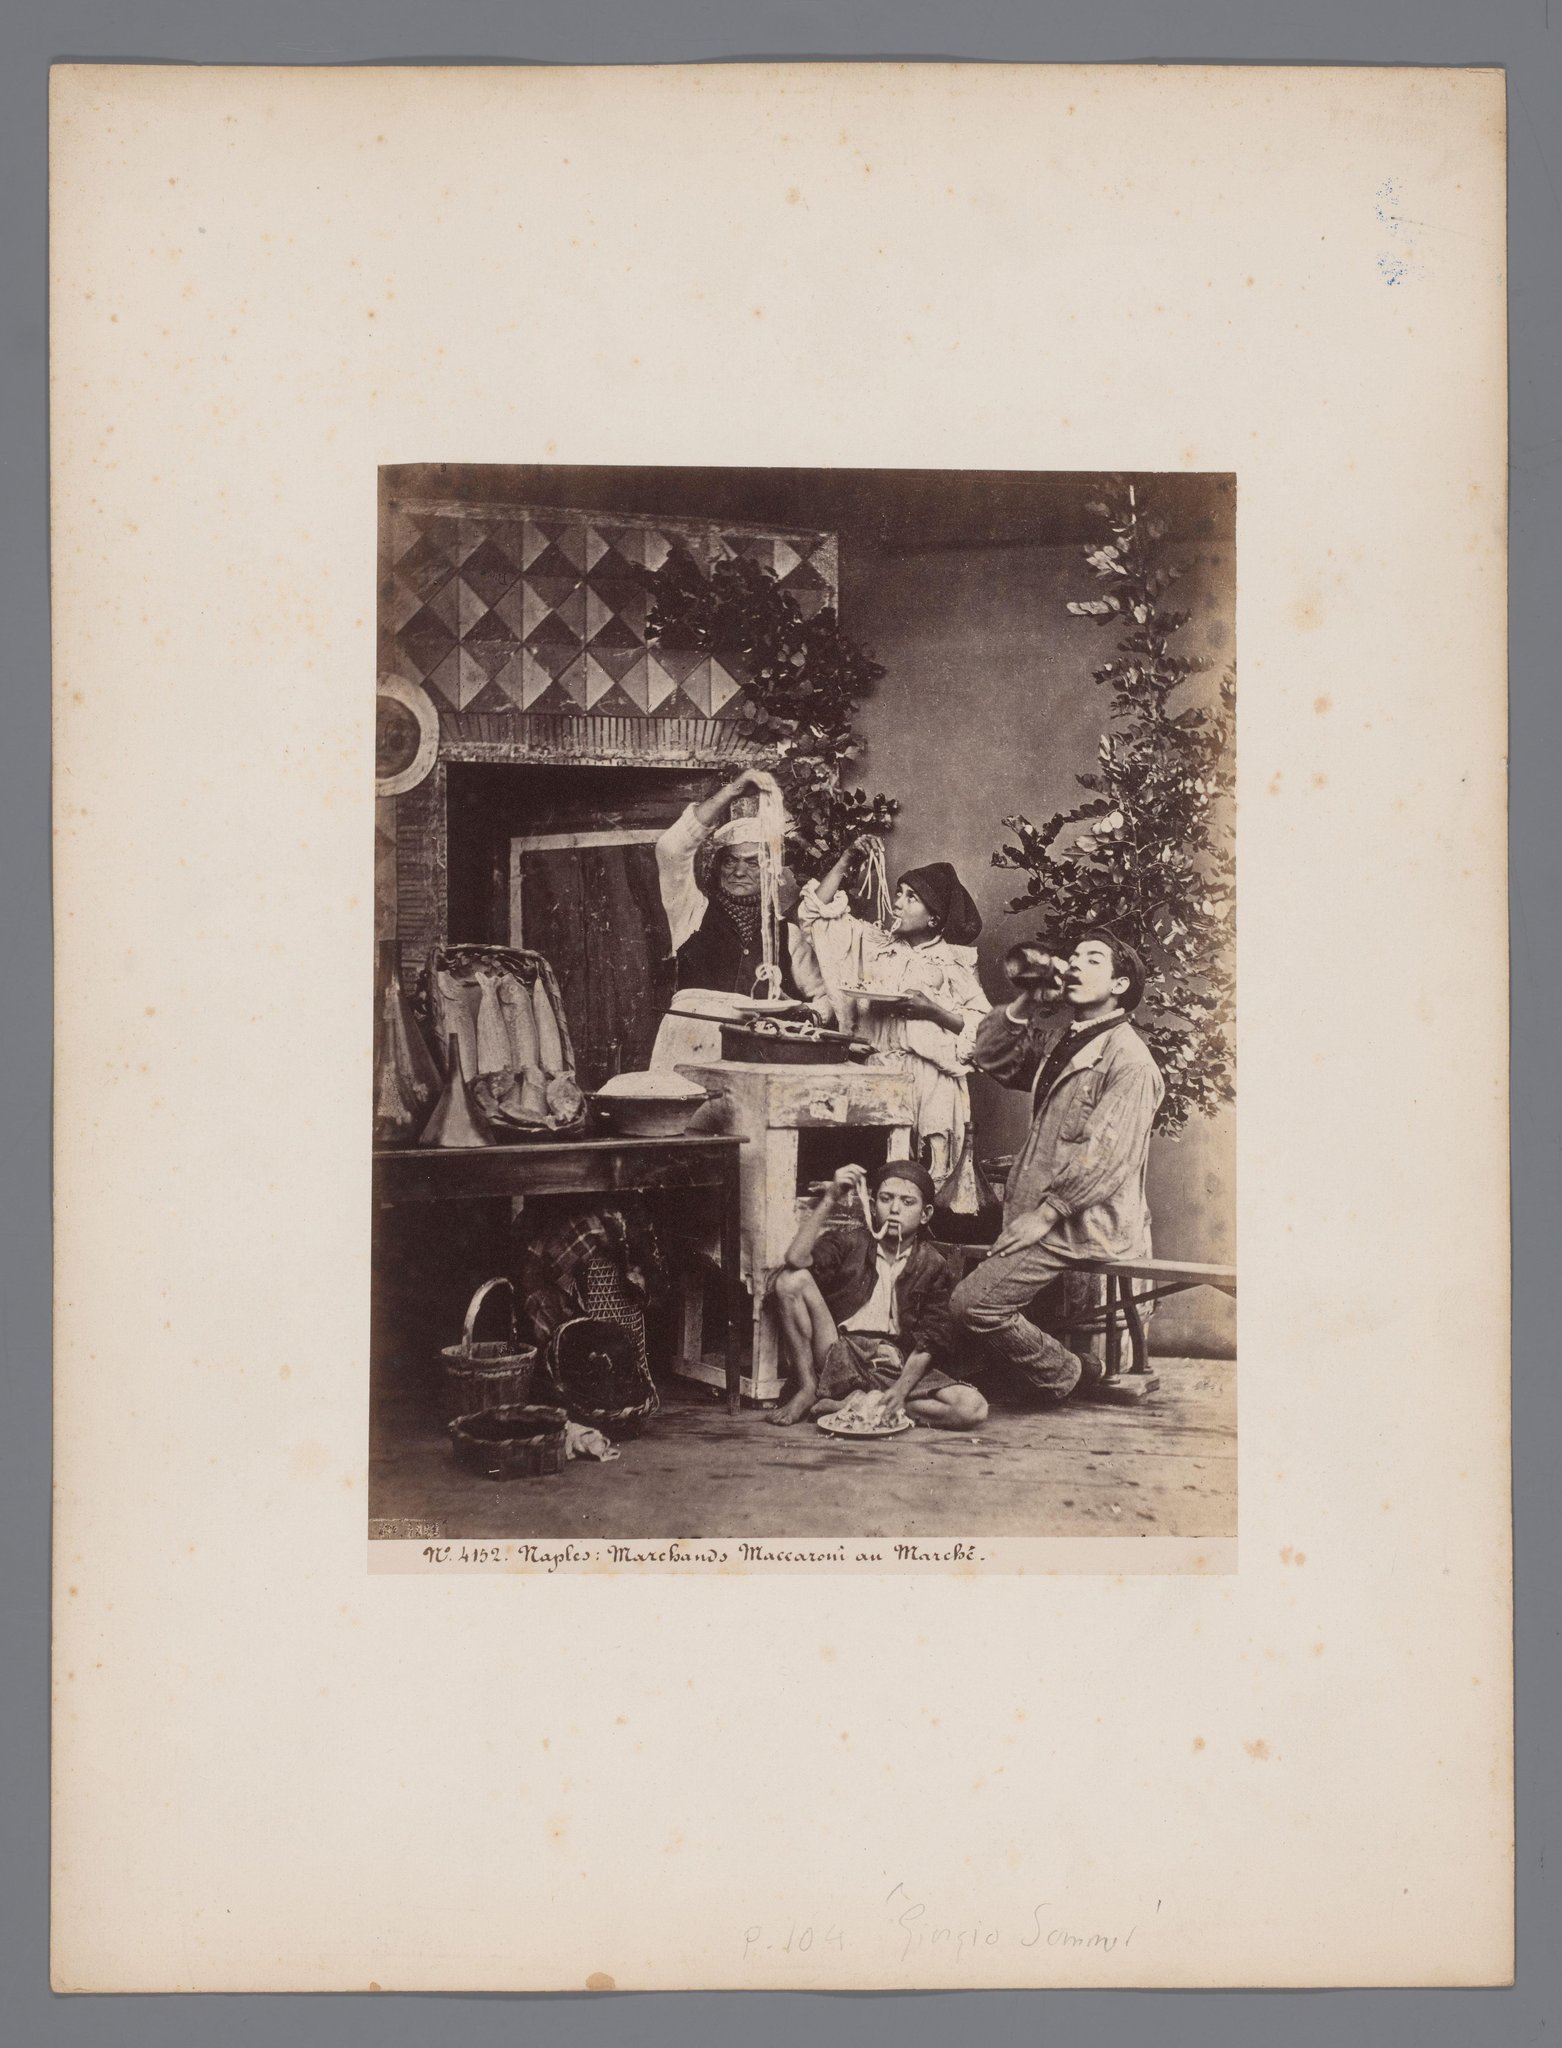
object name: photograph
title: Tafereel met vier mensen die spaghetti eten in Napels, Italië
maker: giorgio sommer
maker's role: fotograaf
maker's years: 1834-1914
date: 1870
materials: cardboard, paper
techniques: albumen print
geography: naples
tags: noodles, spaghetti, etc., naples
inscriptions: number: ‘31.’, number: ‘12’, inscription: ‘p. 104 Giorgio Sommer’, number: ‘No. 4152.’